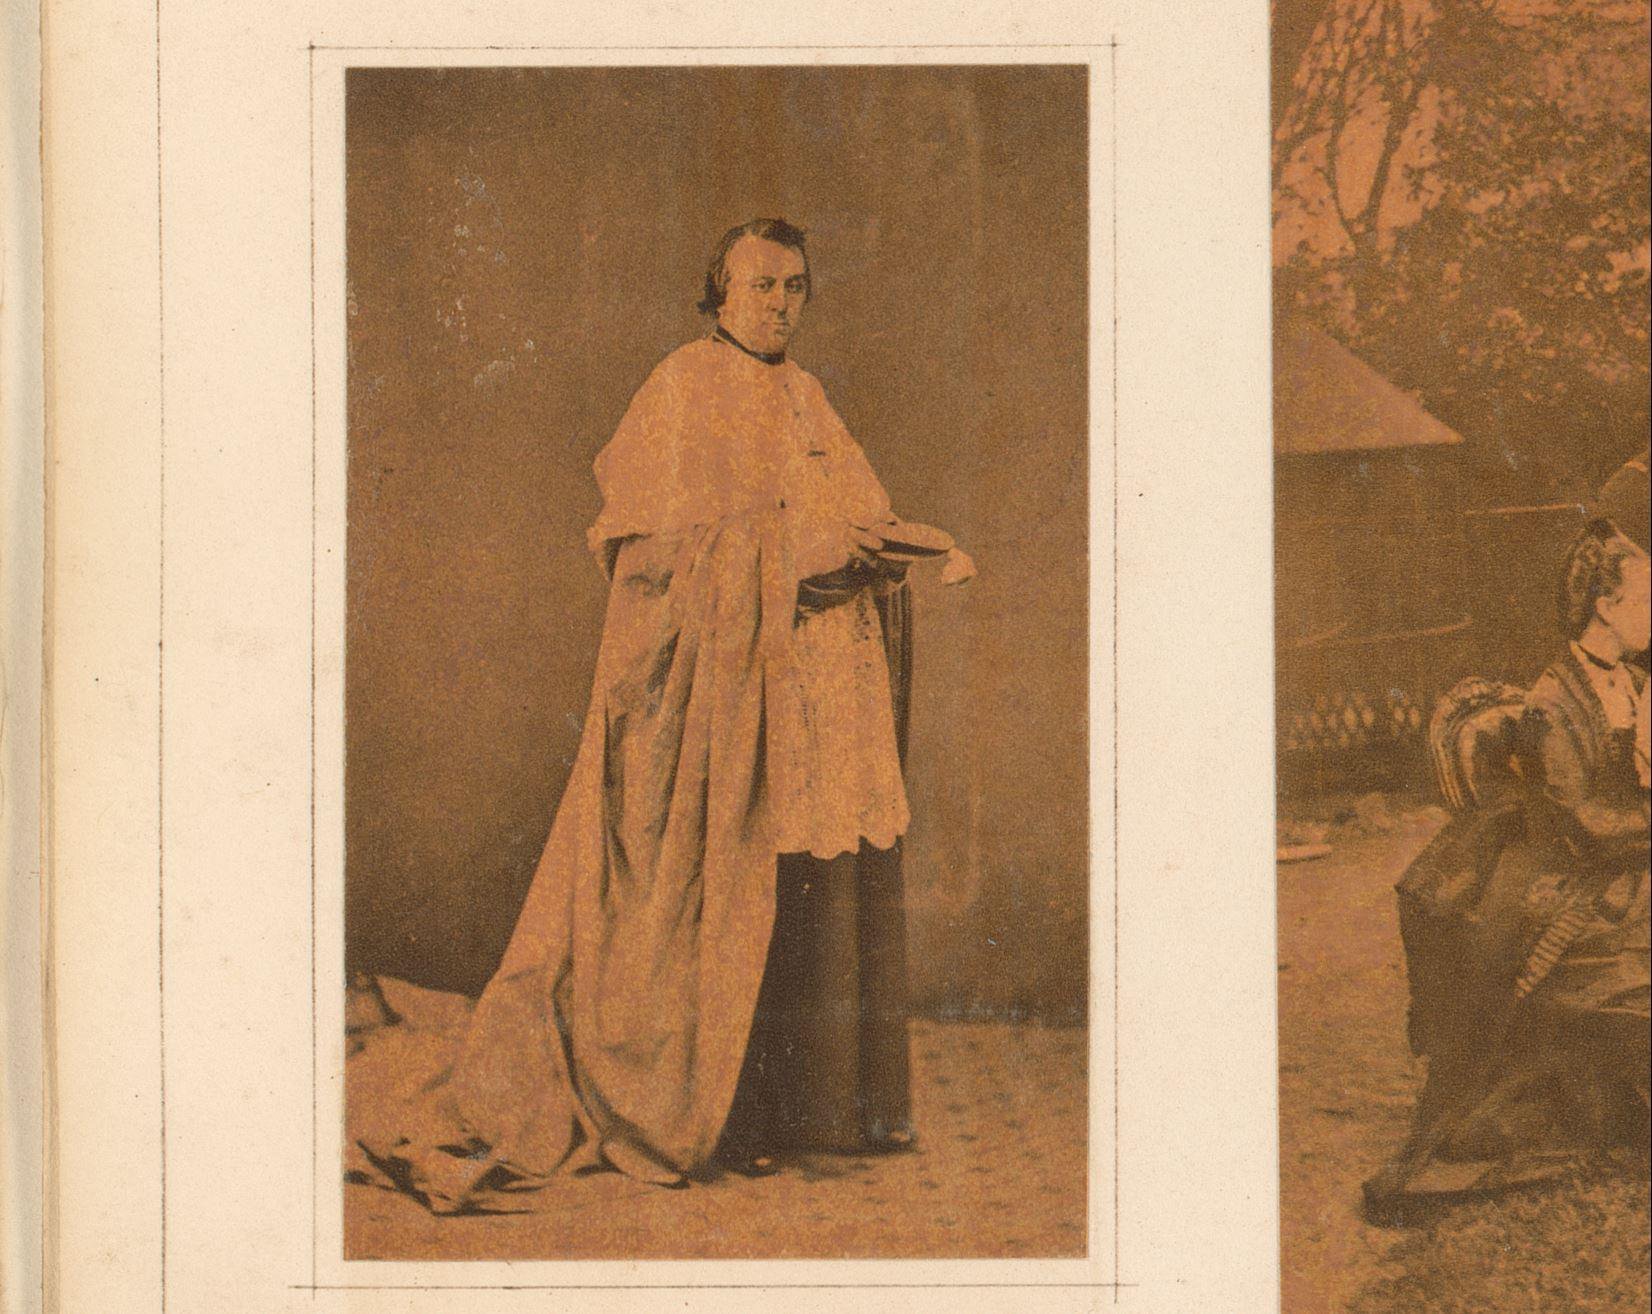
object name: photomechanical print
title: Monseigneur Lavigerie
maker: Anonymous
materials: paper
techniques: rotogravure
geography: france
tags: cardinal, historical persons, france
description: Deze prent maakt deel uit van een album.